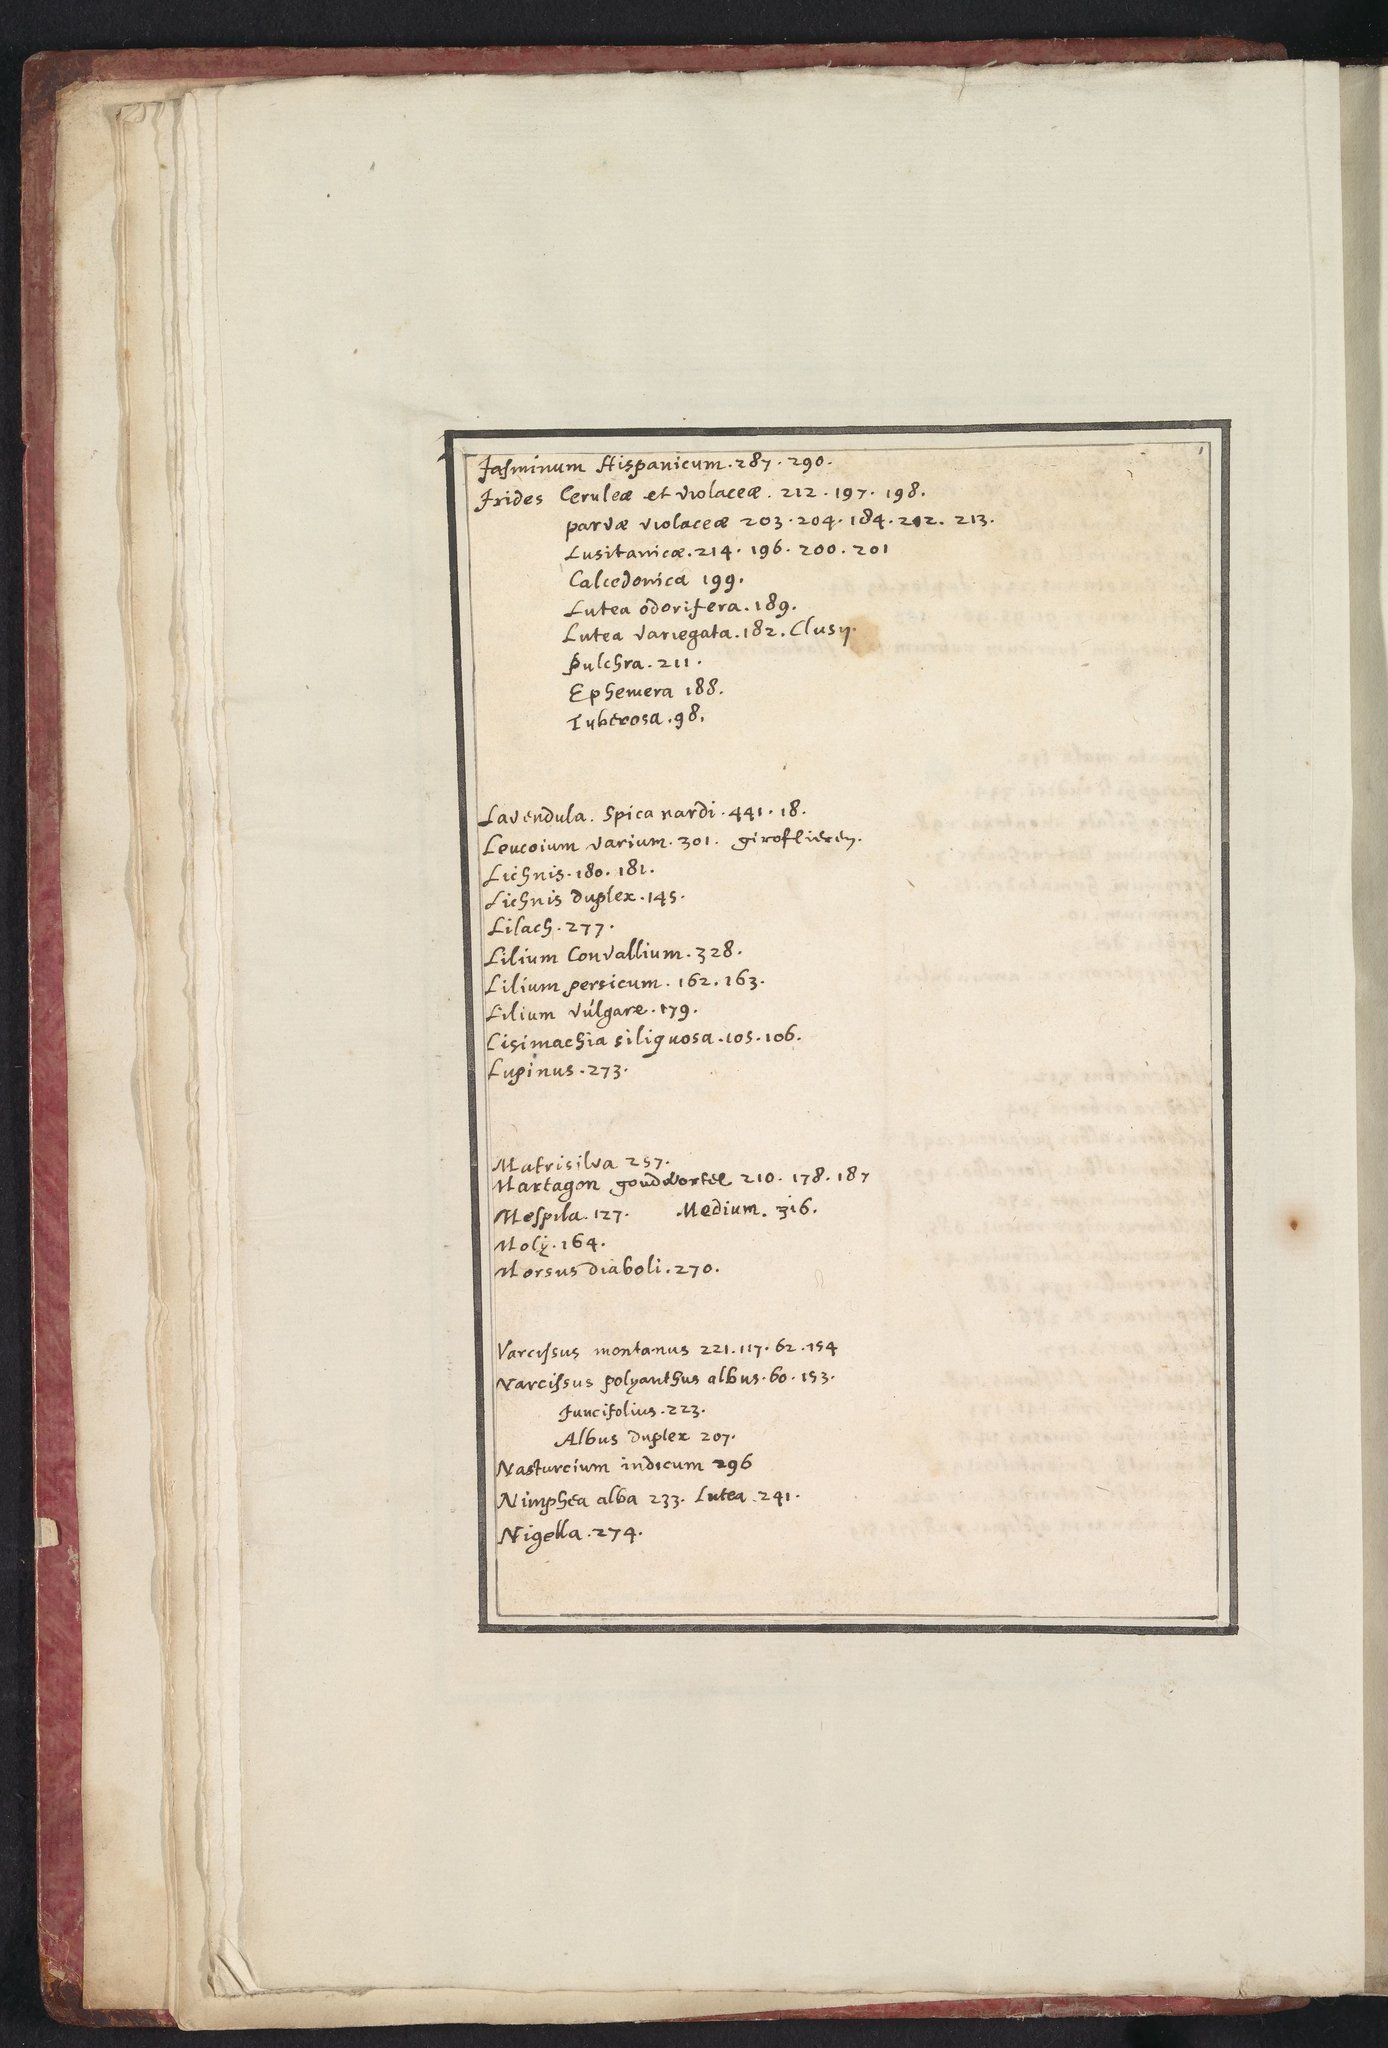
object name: manuscript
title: Alfabetische lijst van de Latijnse namen van de afgebeelde bloemen I-N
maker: anselmus boëtius de boodt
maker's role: draughtsman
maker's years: 1550-1632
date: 1596-1632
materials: ink, paper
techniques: handwriting, pen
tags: handwriting, written text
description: Originele lijst van de Latijnse namen van de bloemen afgebeeld in de vier delen van de planten. Namen beginnend met I-N. Onderdeel van het eerste album met tekeningen van bloemen. Achtste van twaalf albums met tekeningen van dieren, vogels en planten bekend rond 1600, gemaakt in opdracht van keizer Rudolf II. Met toelichting in Nederlands, Latijn en Frans.